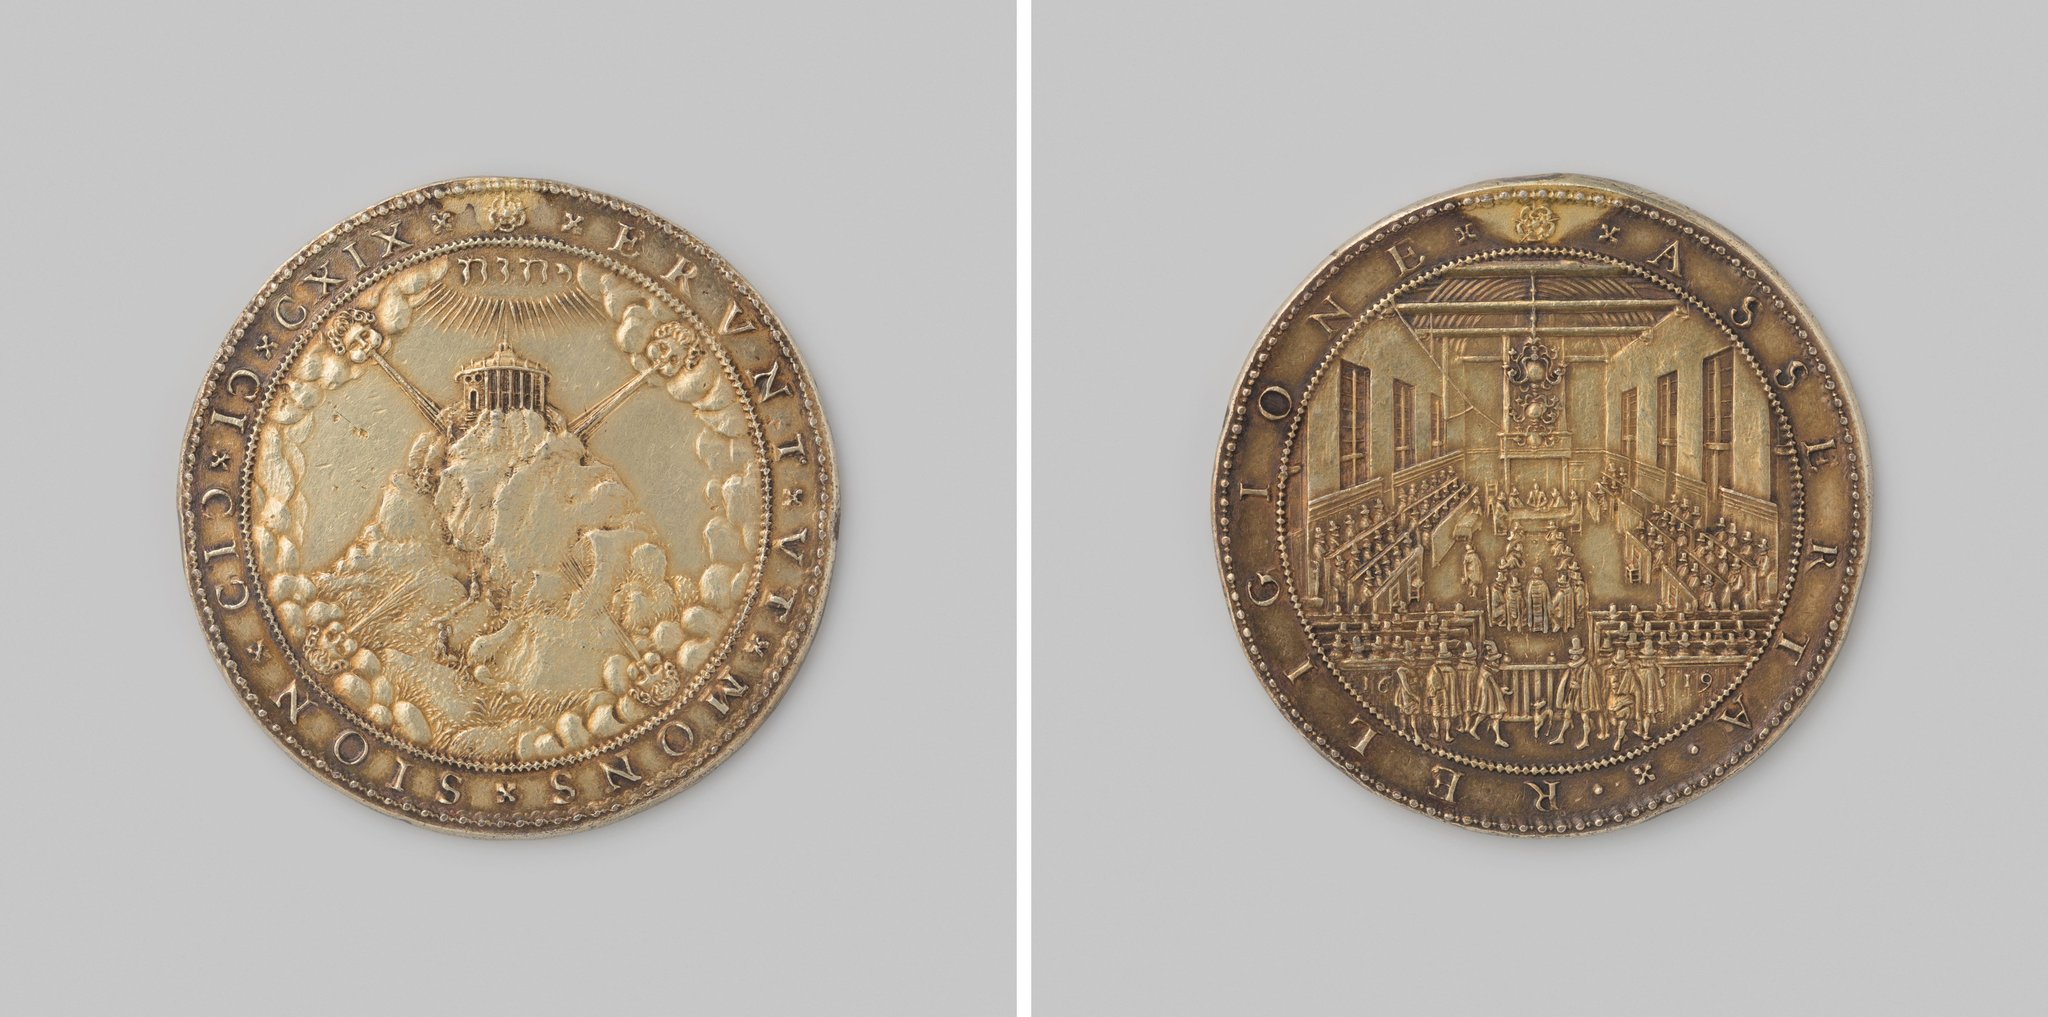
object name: history medal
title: Synode van Dordrecht 1619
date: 1619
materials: silver